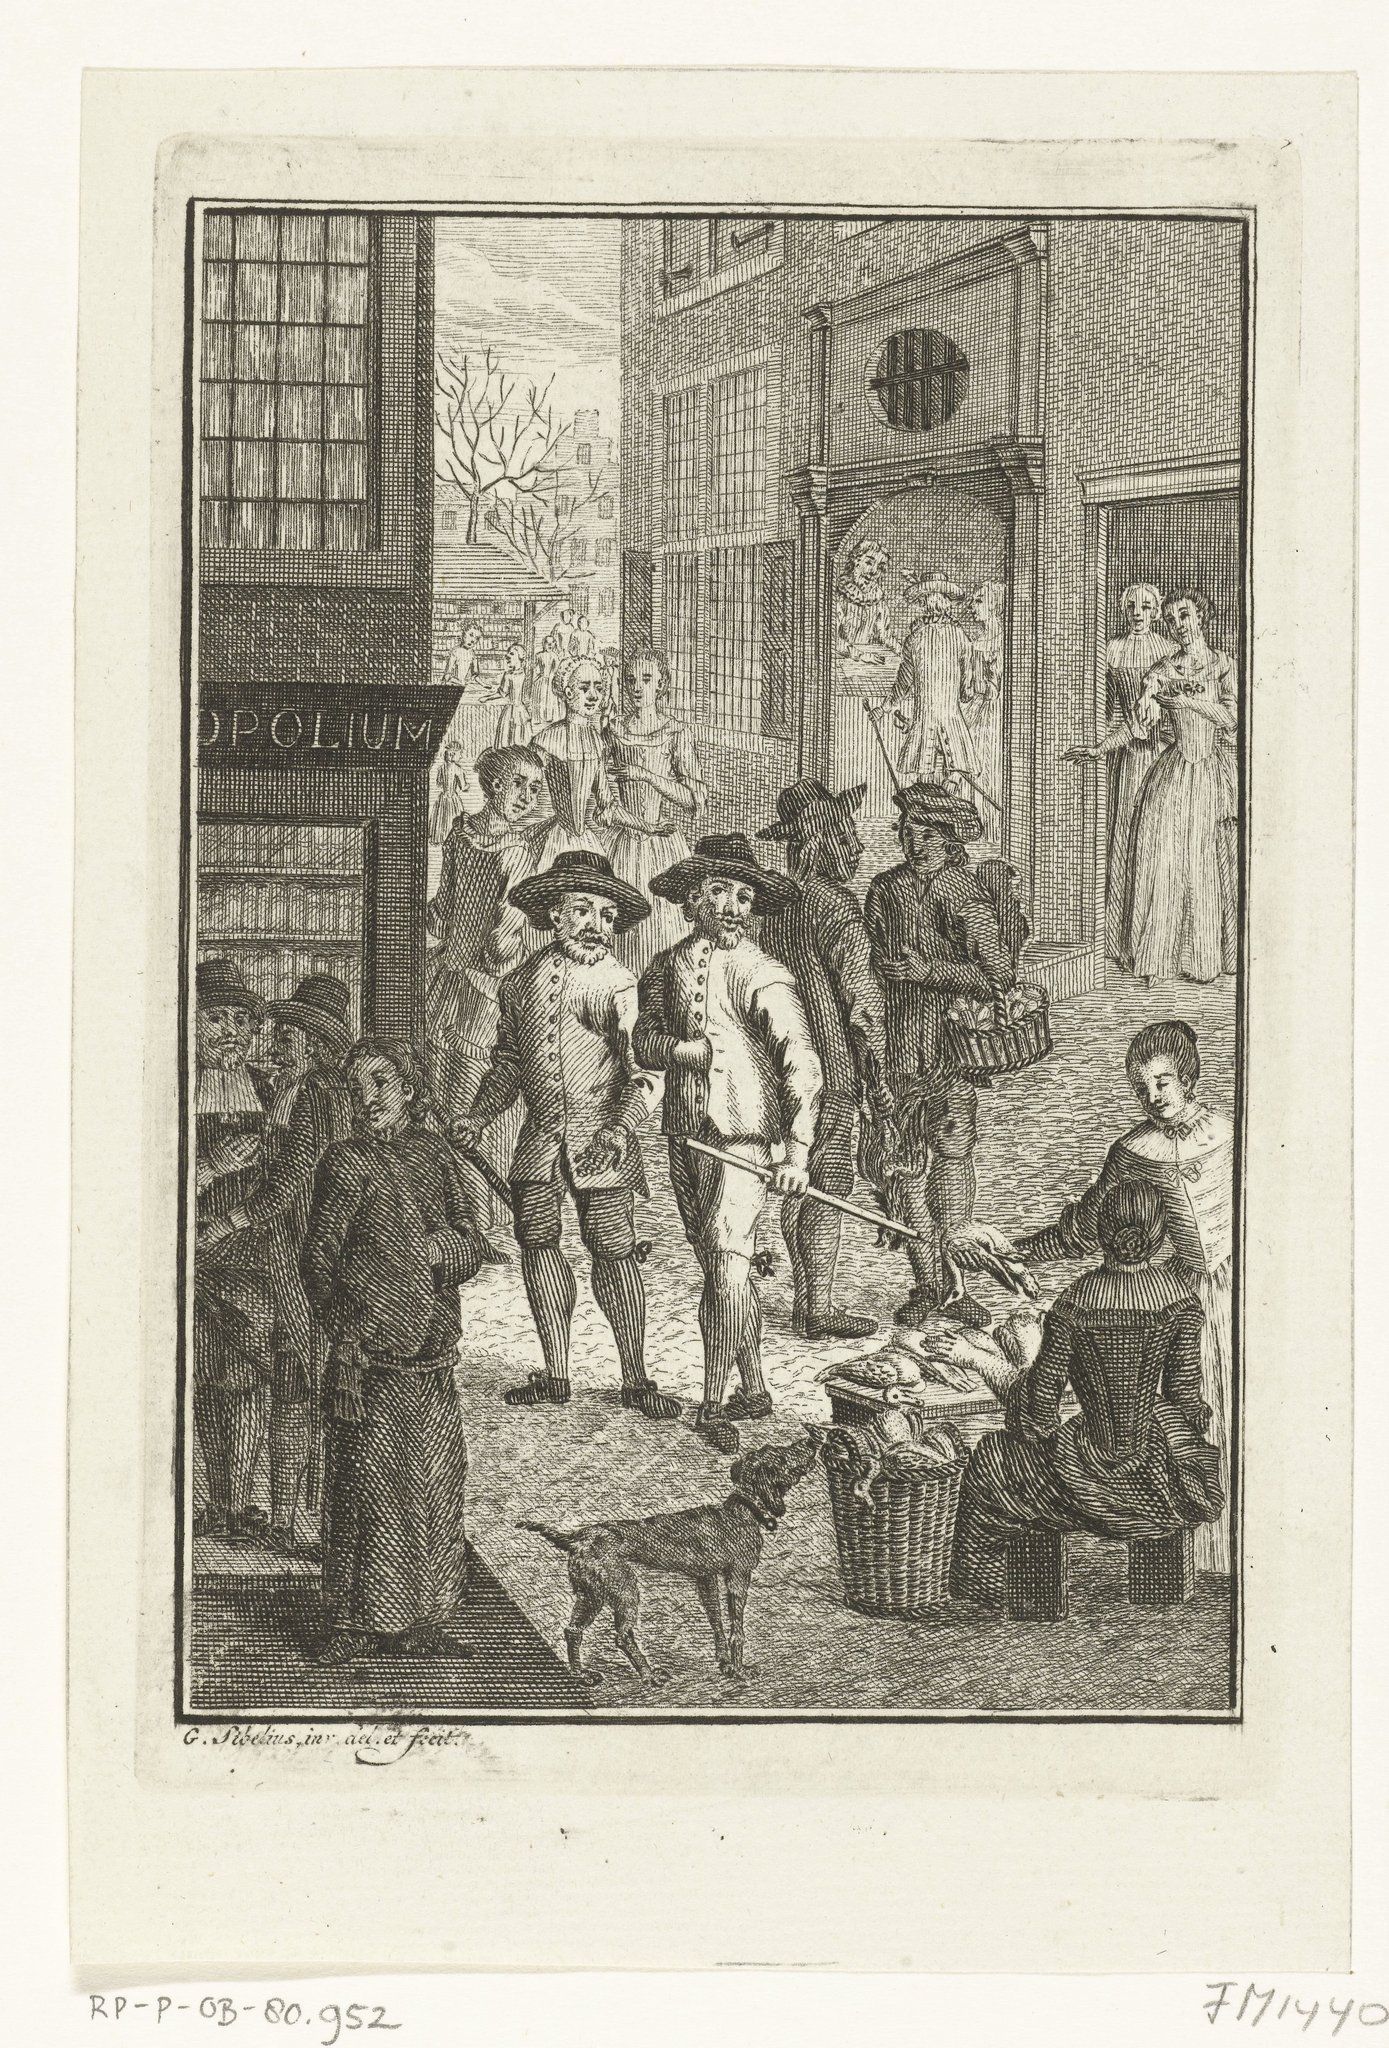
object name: print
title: Hugo de Groot begeeft zich in metselaarskleding op de markt te Gorinchem, 1621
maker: gerard sibelius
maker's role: print maker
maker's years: 1734-1785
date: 1768-1771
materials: paper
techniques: engraving, etching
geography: netherlands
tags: delft, hugo de groot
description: Hugo de Groot begeeft zich na zijn ontsnapping uit Slot Loevestein op 22 maart 1621 in metselaarskleding op de markt te Gorinchem, samen met Abraham Daatselaar.